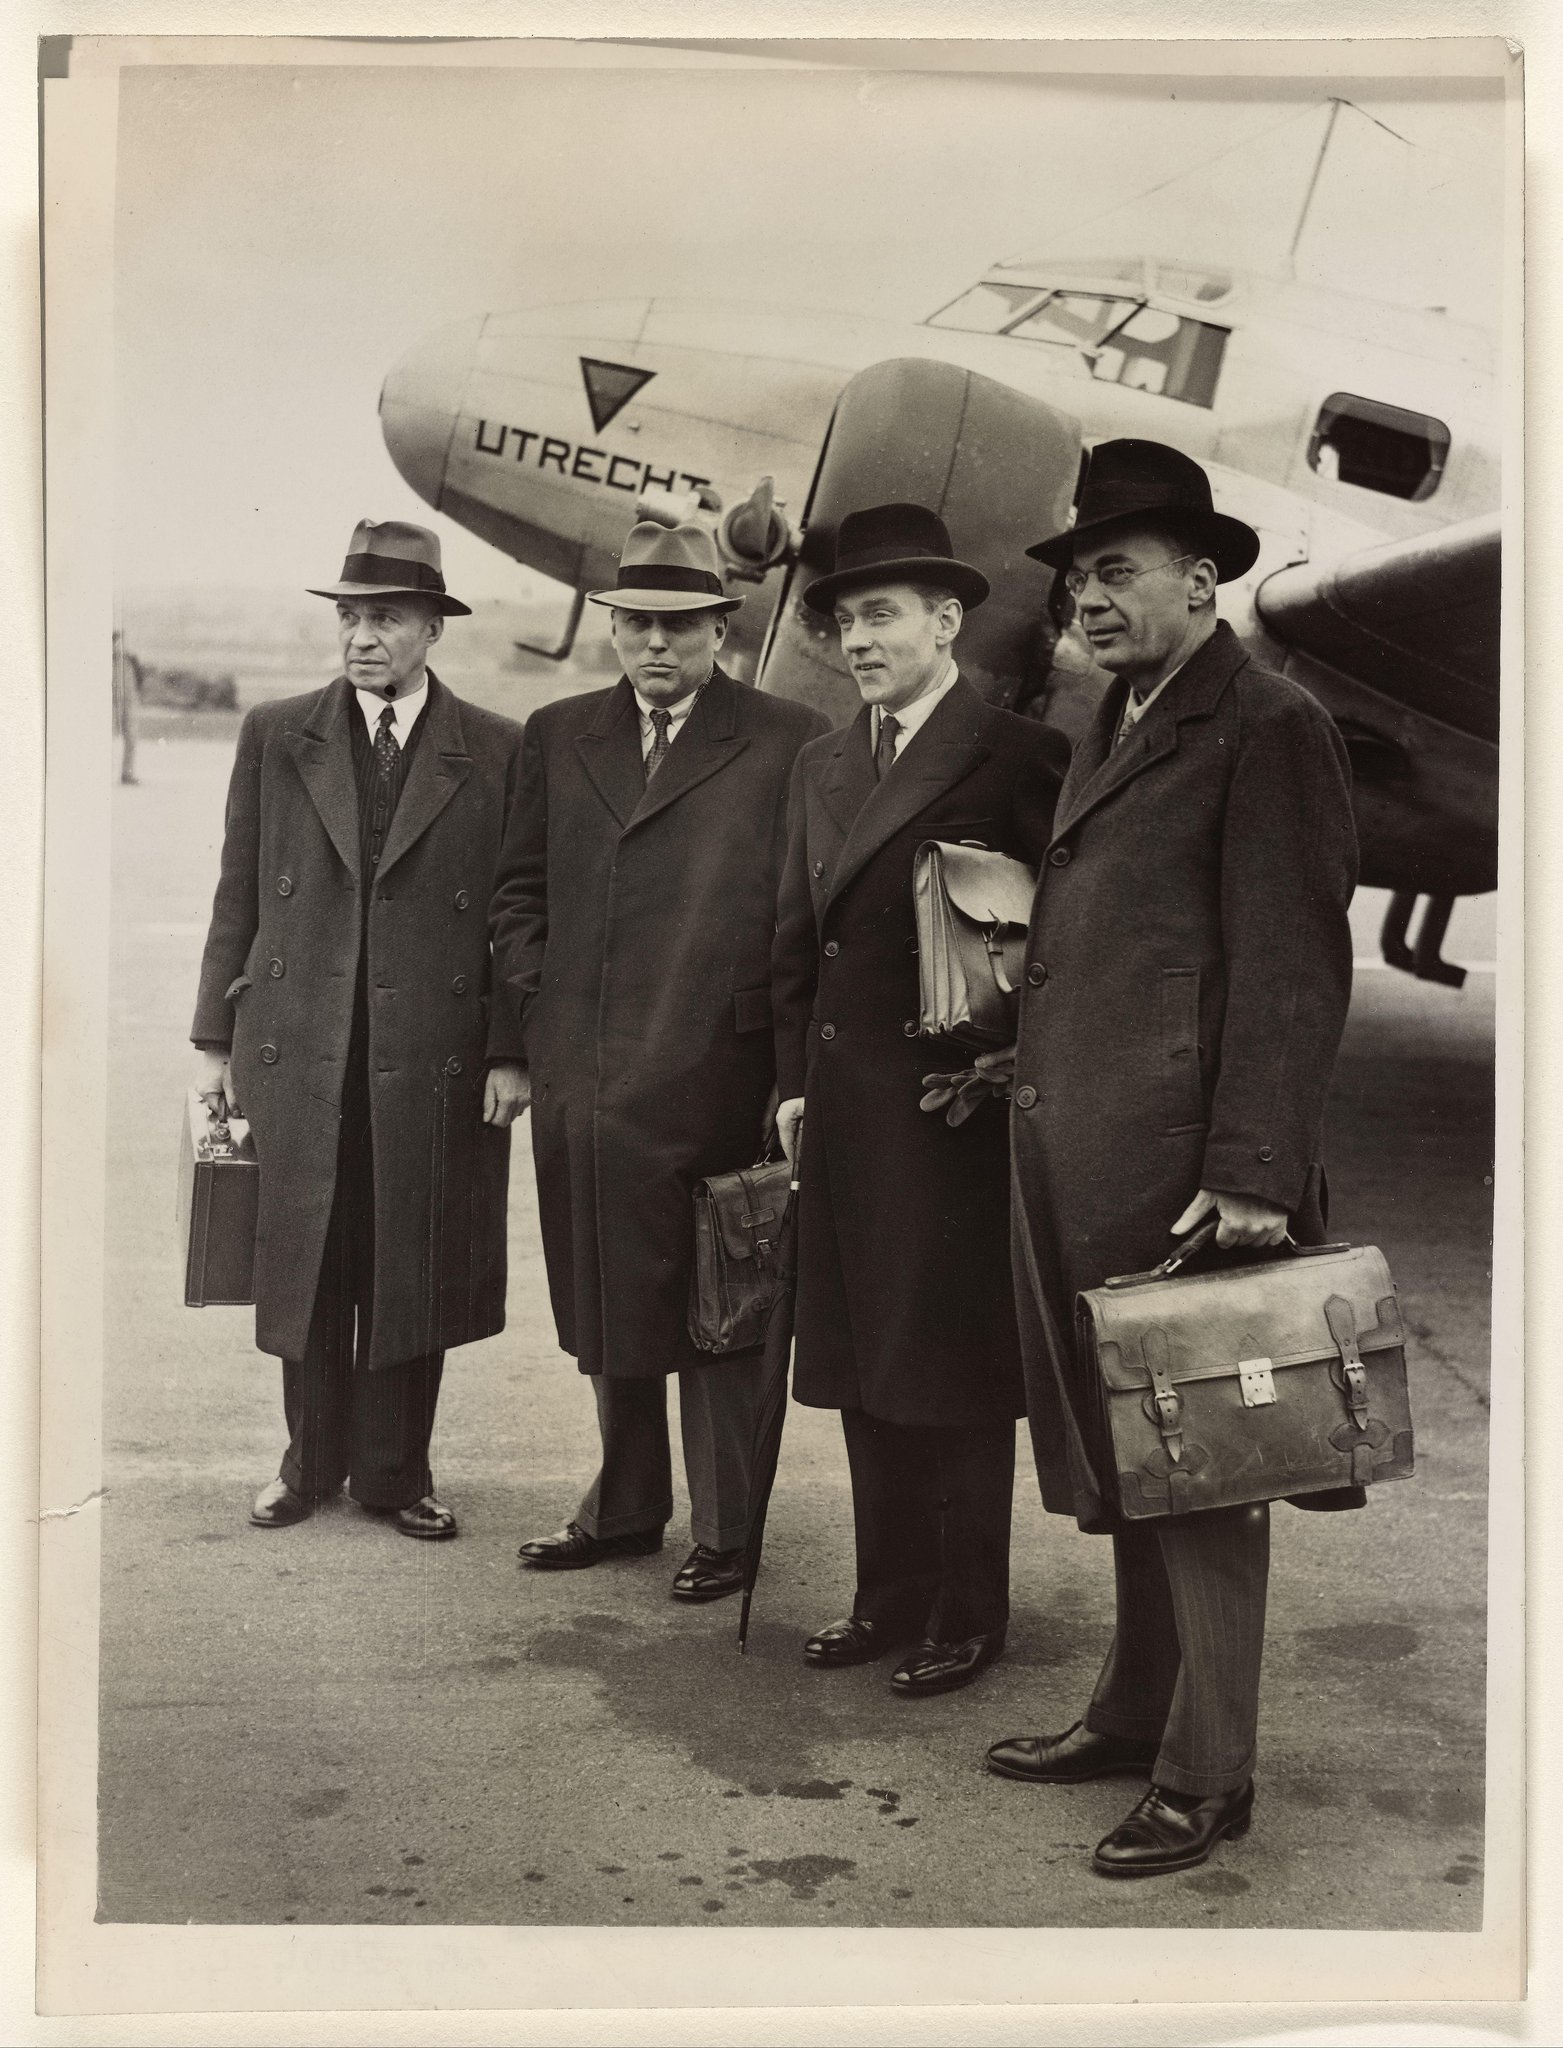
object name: documentary photograph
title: Minister-president Schermerhorn arriveert in Londen voor gesprek over de toekomst van Nederlands-Indië met zijn collega Attlee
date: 1946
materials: photographic support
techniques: photography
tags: france, hubertus johannes van mook, haarlem, politician, willem schermerhorn, rotterdam, london, indonesia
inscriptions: number: ‘505184’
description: Vier heren in pak, met hoed en aktetassen zijn gefotografeerd kort na aankomst op het vliegveld Hendon nabij Londen met op de achtergrond het vliegtuig 'Utrecht'. Met van links naar rechts: minister van Overzeese gebiedsdelen Logemann, minister-president Schermerhorn, minister van Buitenlandse Zaken Van Roijen en gouverneur-generaal van Nederlands-Indië Van Mook.